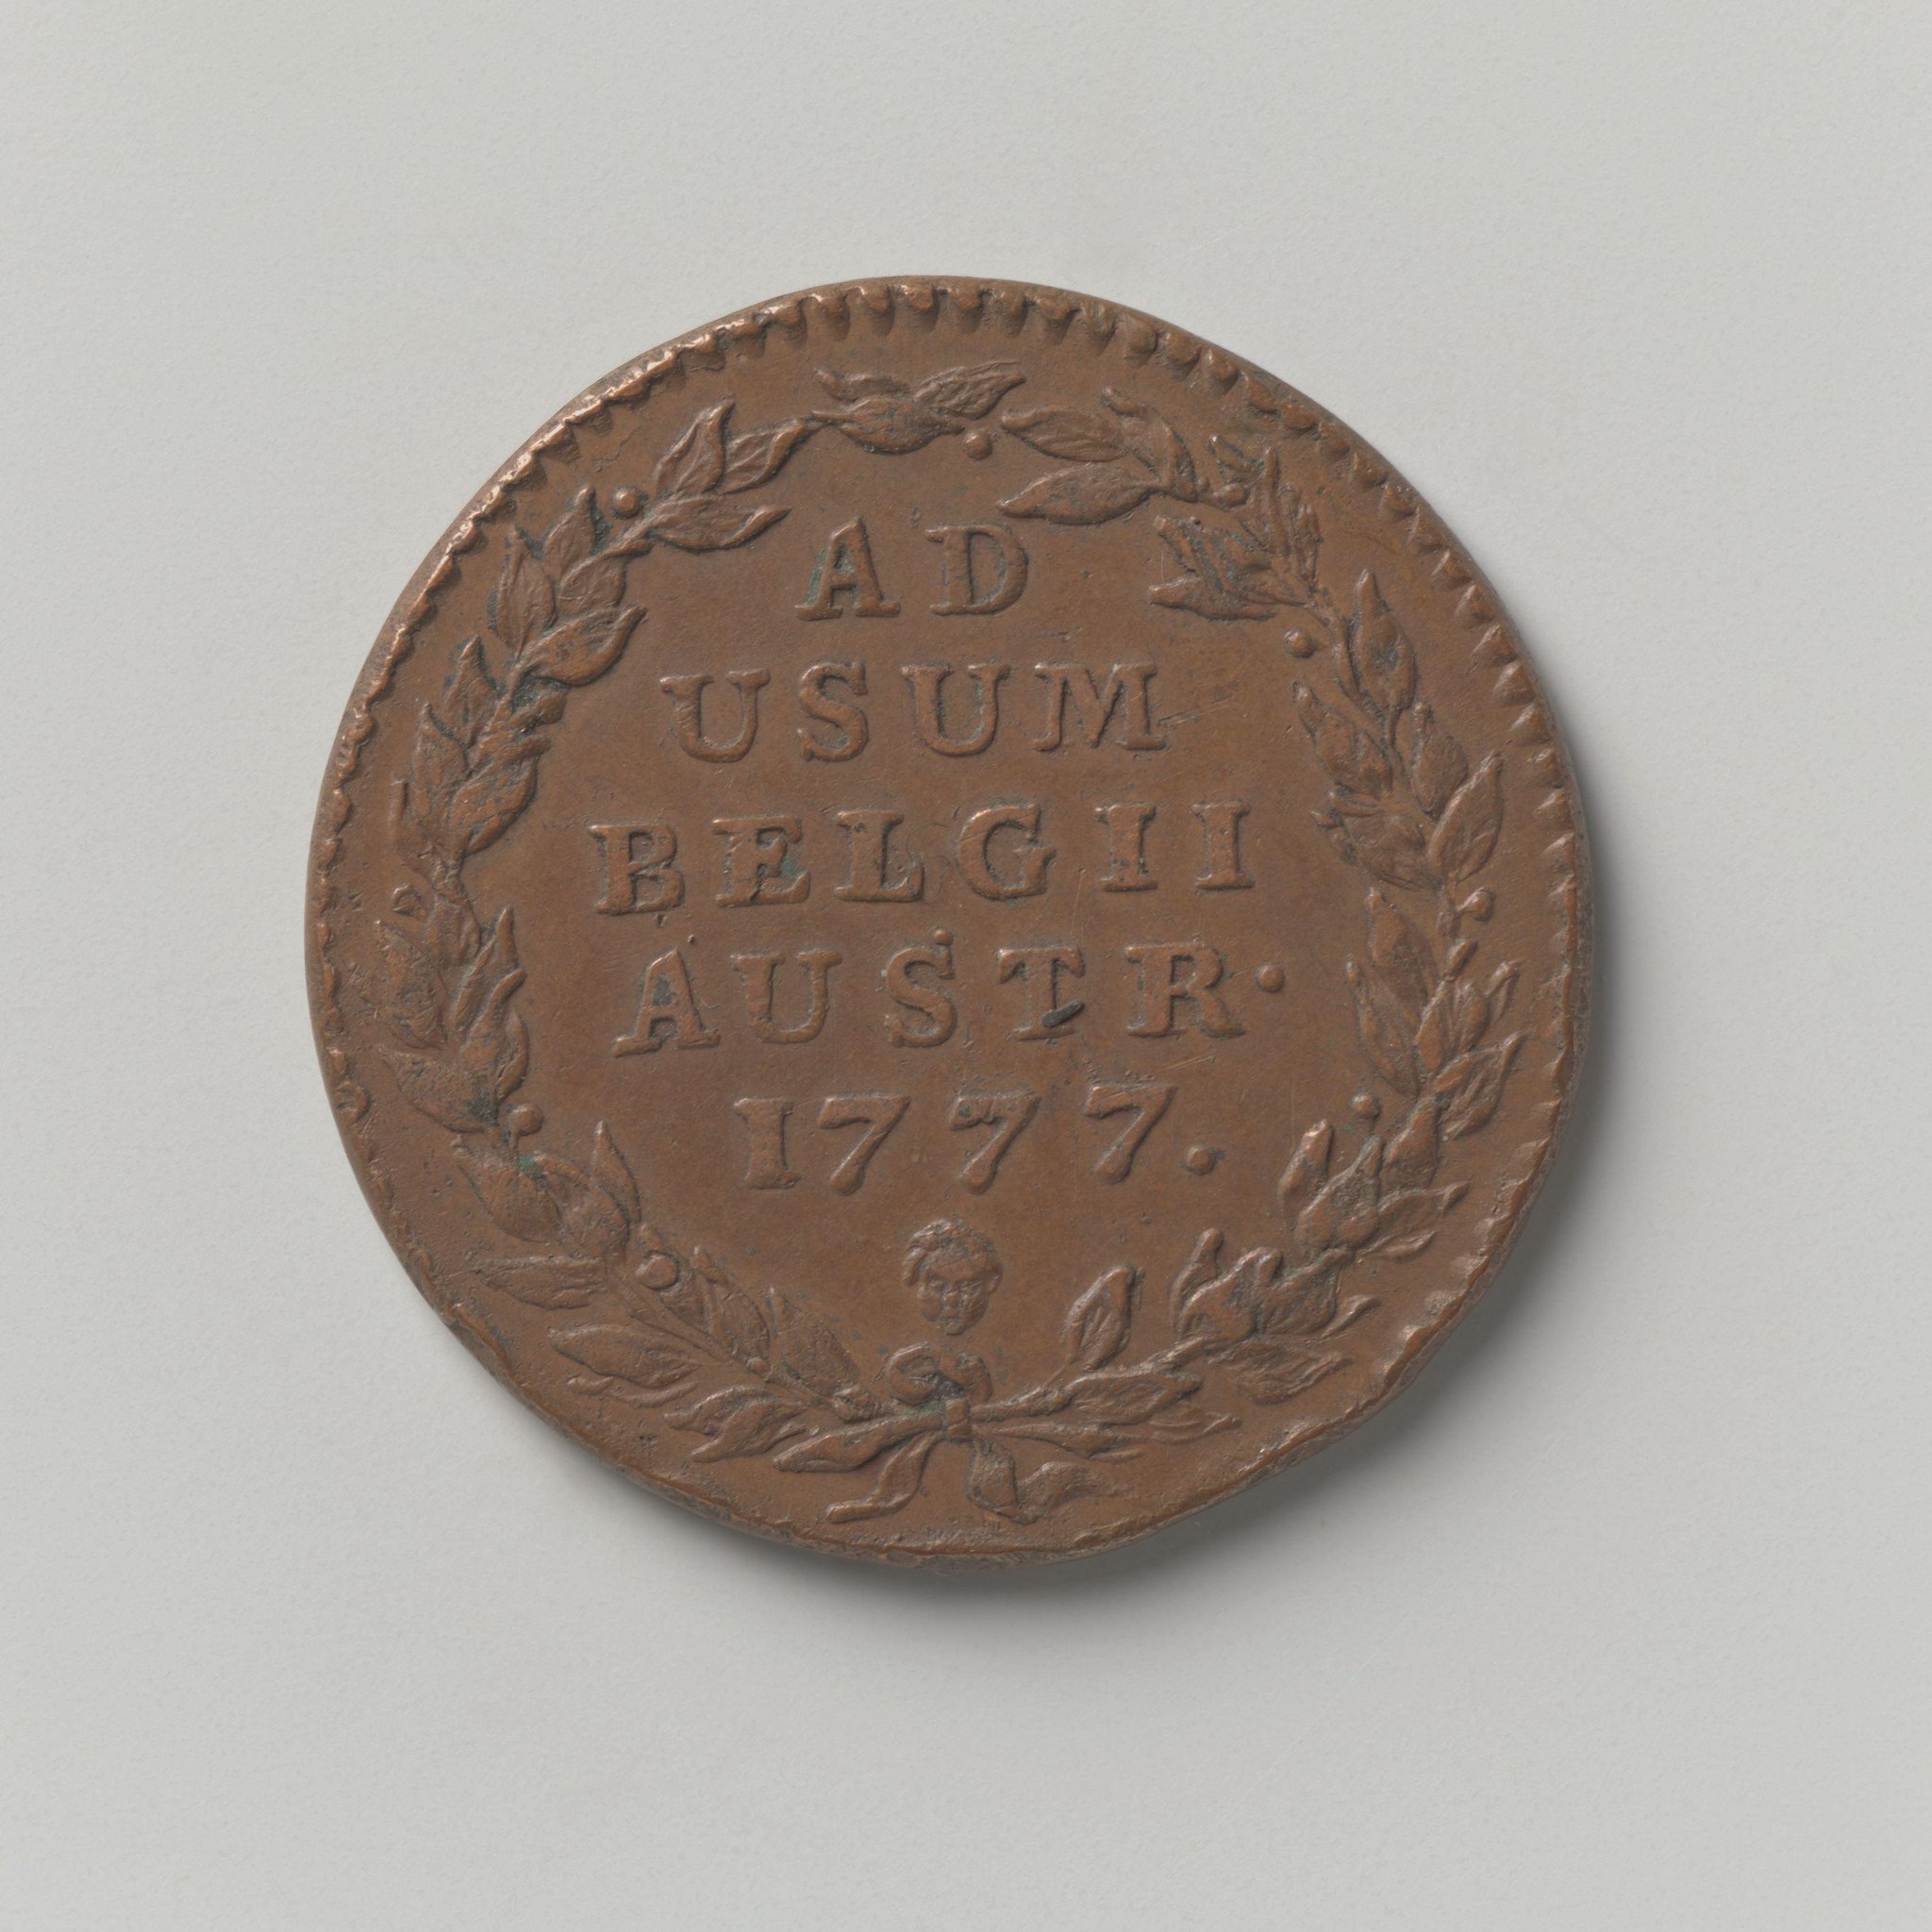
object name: dubbele oord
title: Brabant, Maria-Theresia, dubbele oord, 1777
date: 1777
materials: copper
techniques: striking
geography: brussels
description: Koperen munt. Voorzijde: portret van Maria-Theresia naar rechts. Keerzijde: binnen twee samengebonden lauwertakken vierregelig opschrift, waaronder jaartal. Daaronder engelenkop.